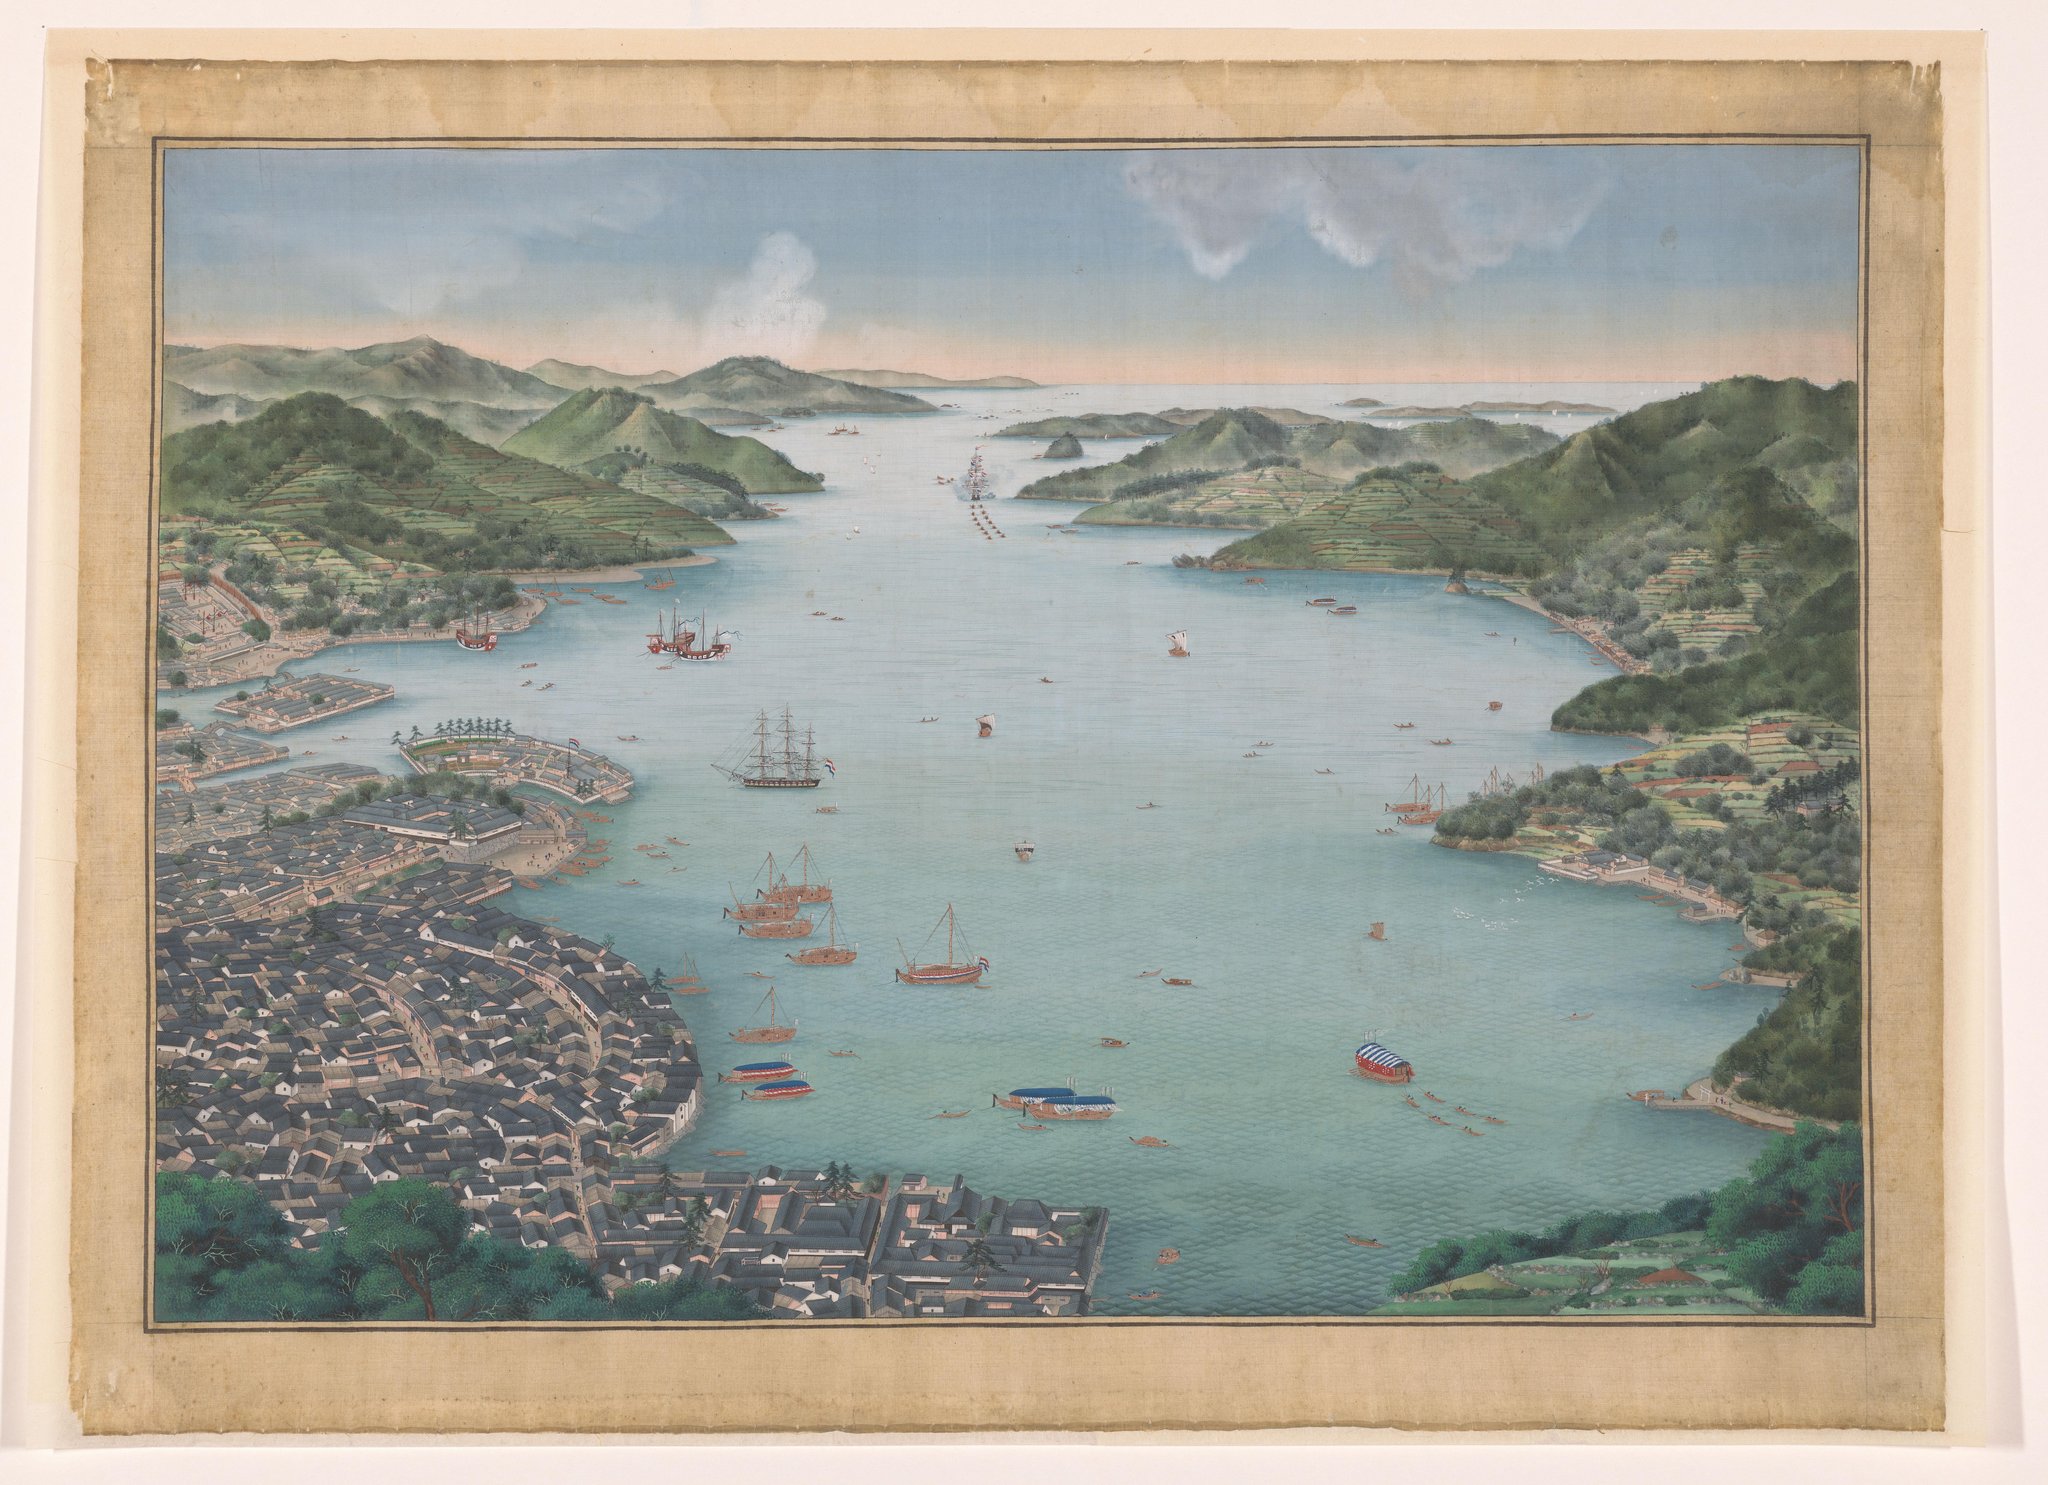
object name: painting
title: View of Nagasaki bay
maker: kawahara keiga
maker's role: painter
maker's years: 1786-1860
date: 1833-1836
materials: silk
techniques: brush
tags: prospect of city, town panorama, silhouette of city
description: Gezicht in vogelvluchtperspectief van de baai van Nagasaki, met talloze Japanse schepen, twee Nederlandse schepen en drie Chinese schepen. Links in het midden de Chinese handelsvestiging, met daarnaast de Nederlandse handelsvestiging op het waaiervormige eiland Deshima.